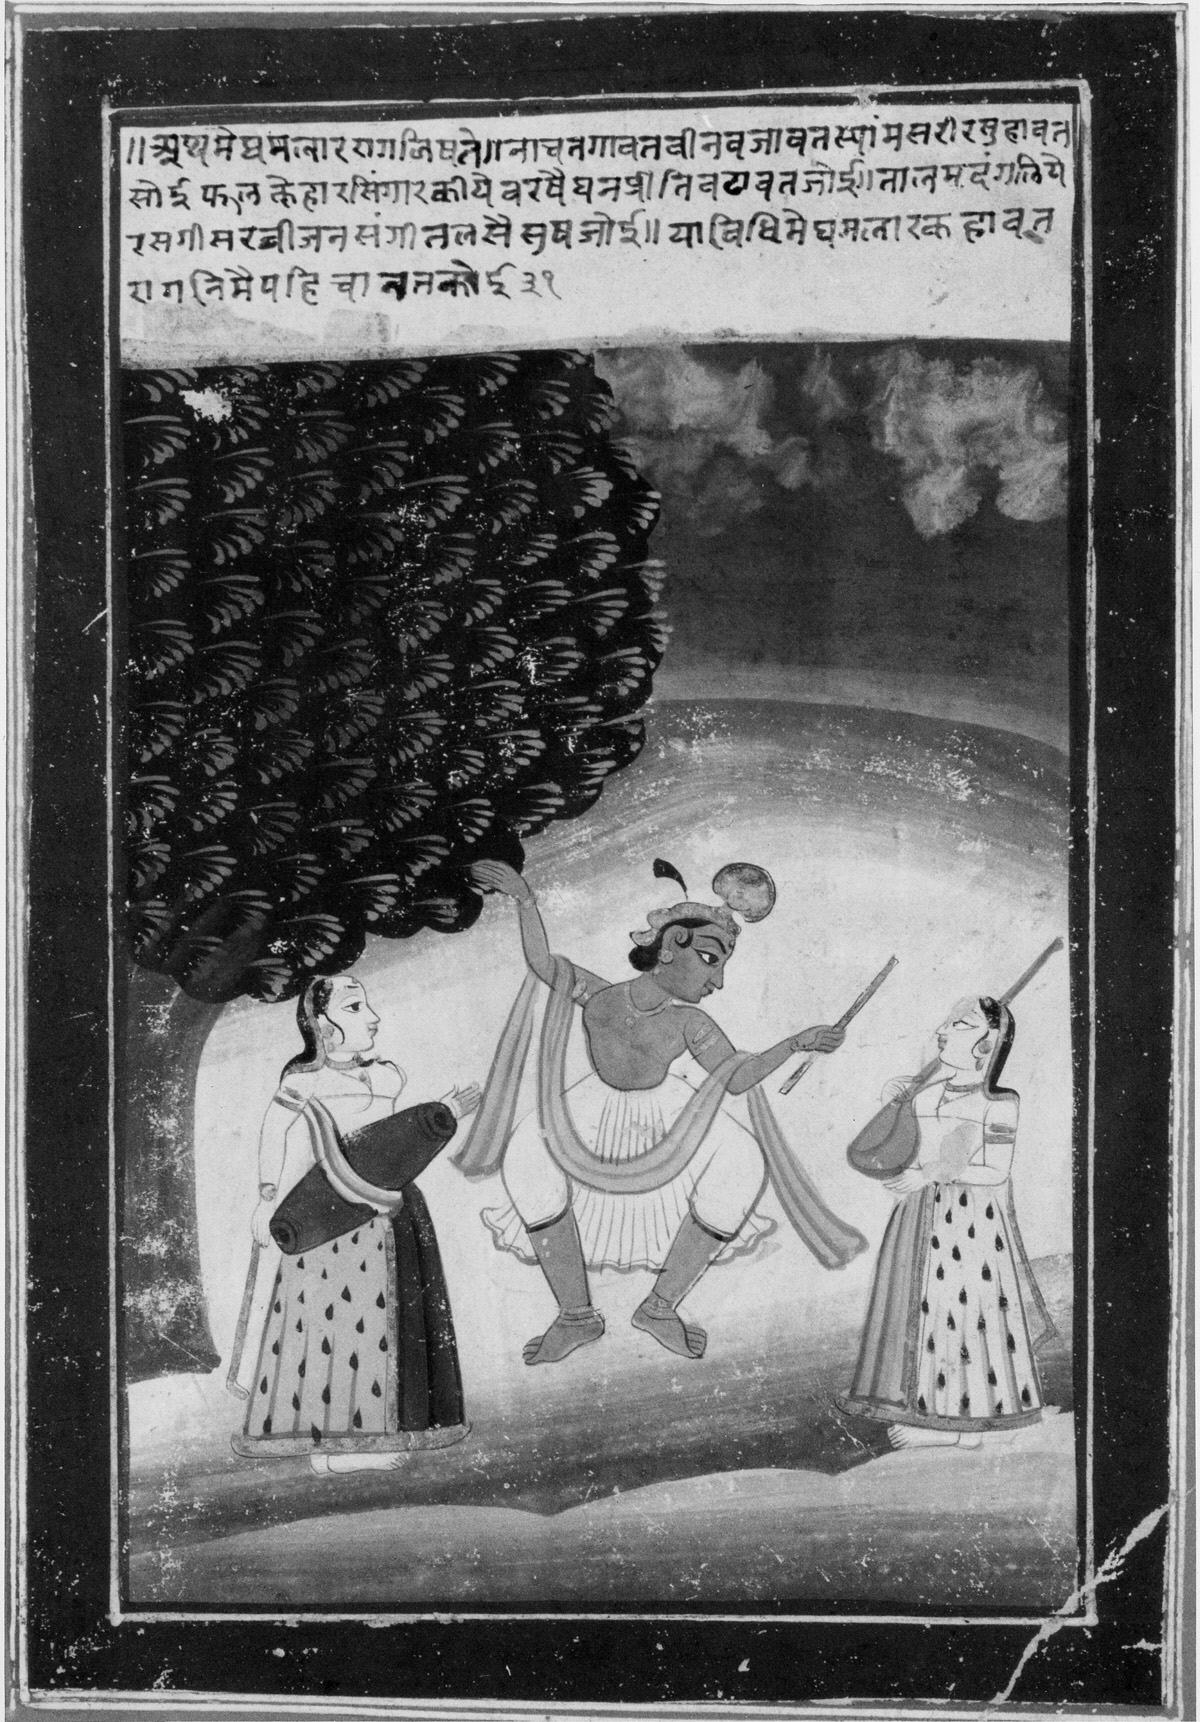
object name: leaf from a ragamala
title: Krishna Dancing with Two Attendant Female Musicians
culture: indian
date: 1867-1933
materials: gold, paper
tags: musical instruments,women,dancing,krishna,musicians